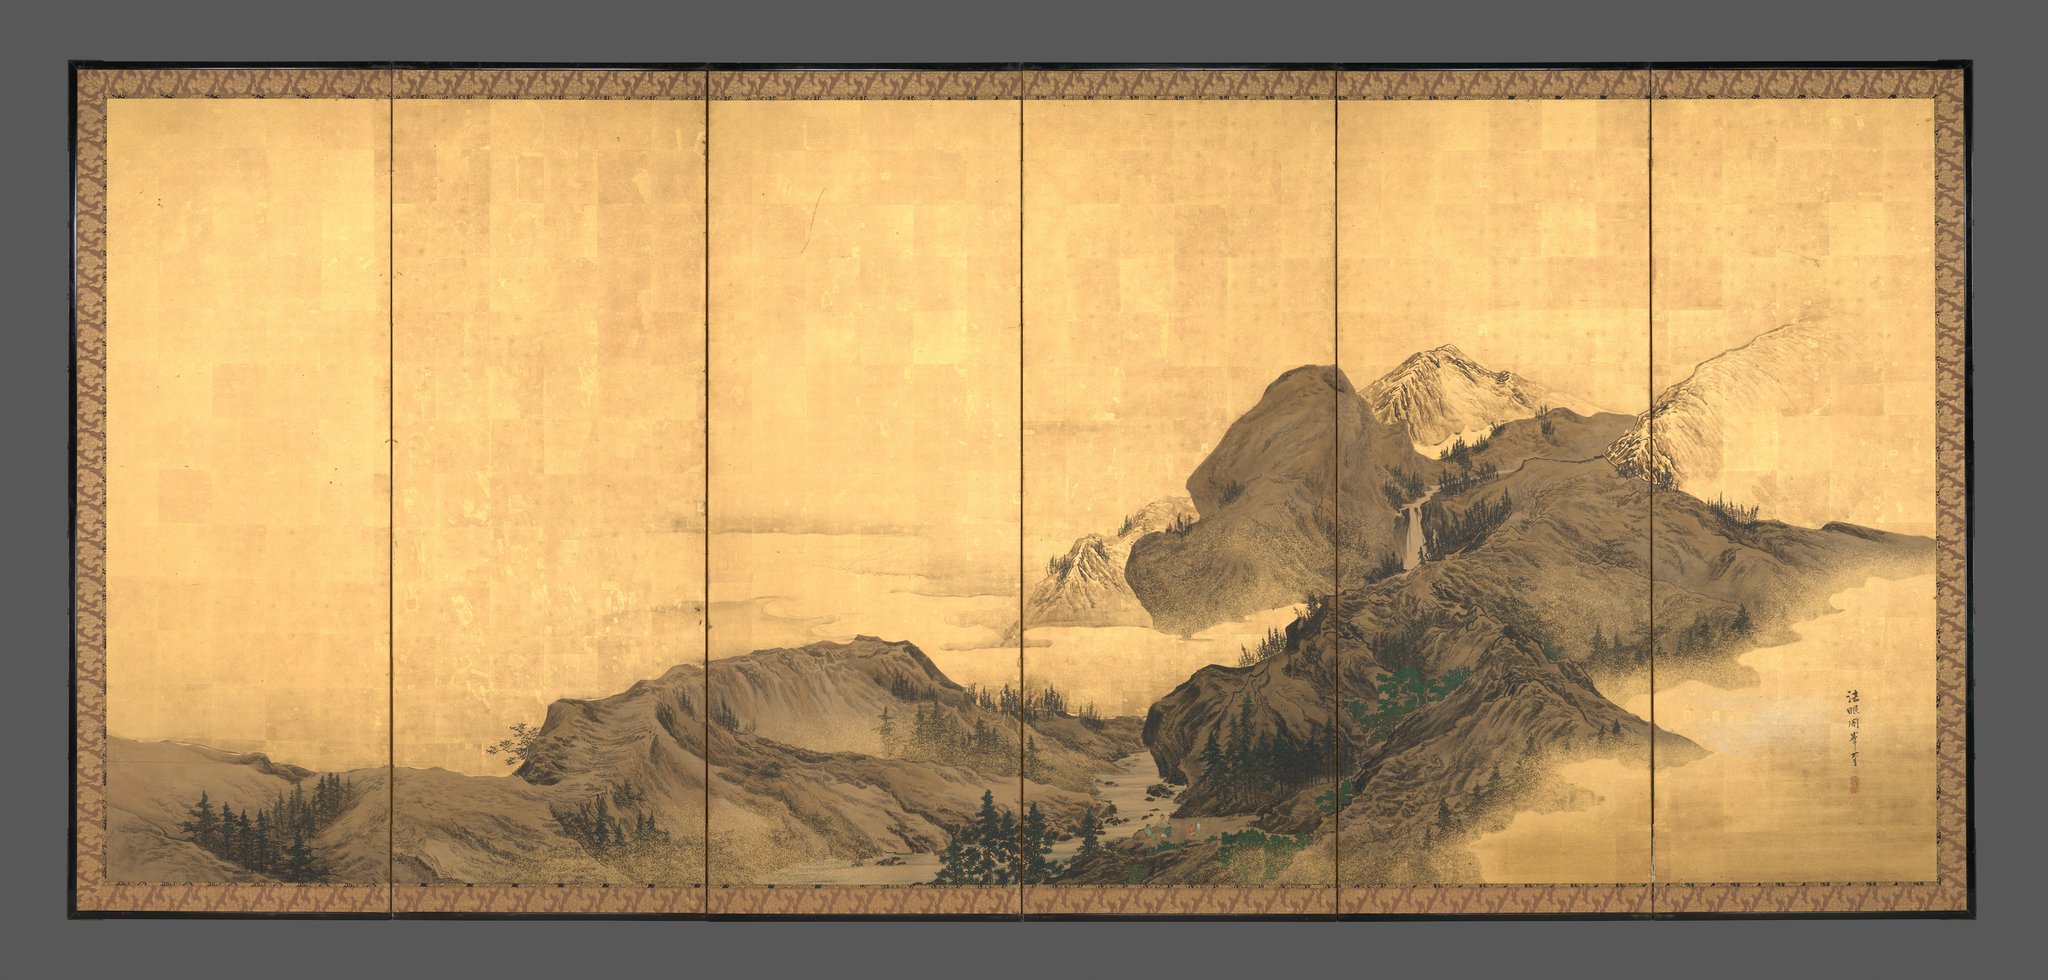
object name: screen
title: Landscape with Pavilion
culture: japanese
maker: mori shūhō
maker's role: artist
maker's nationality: japanese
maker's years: 1738-1823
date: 1801-1833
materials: gold, gold leaf, ink, panel, paper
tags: landscapes